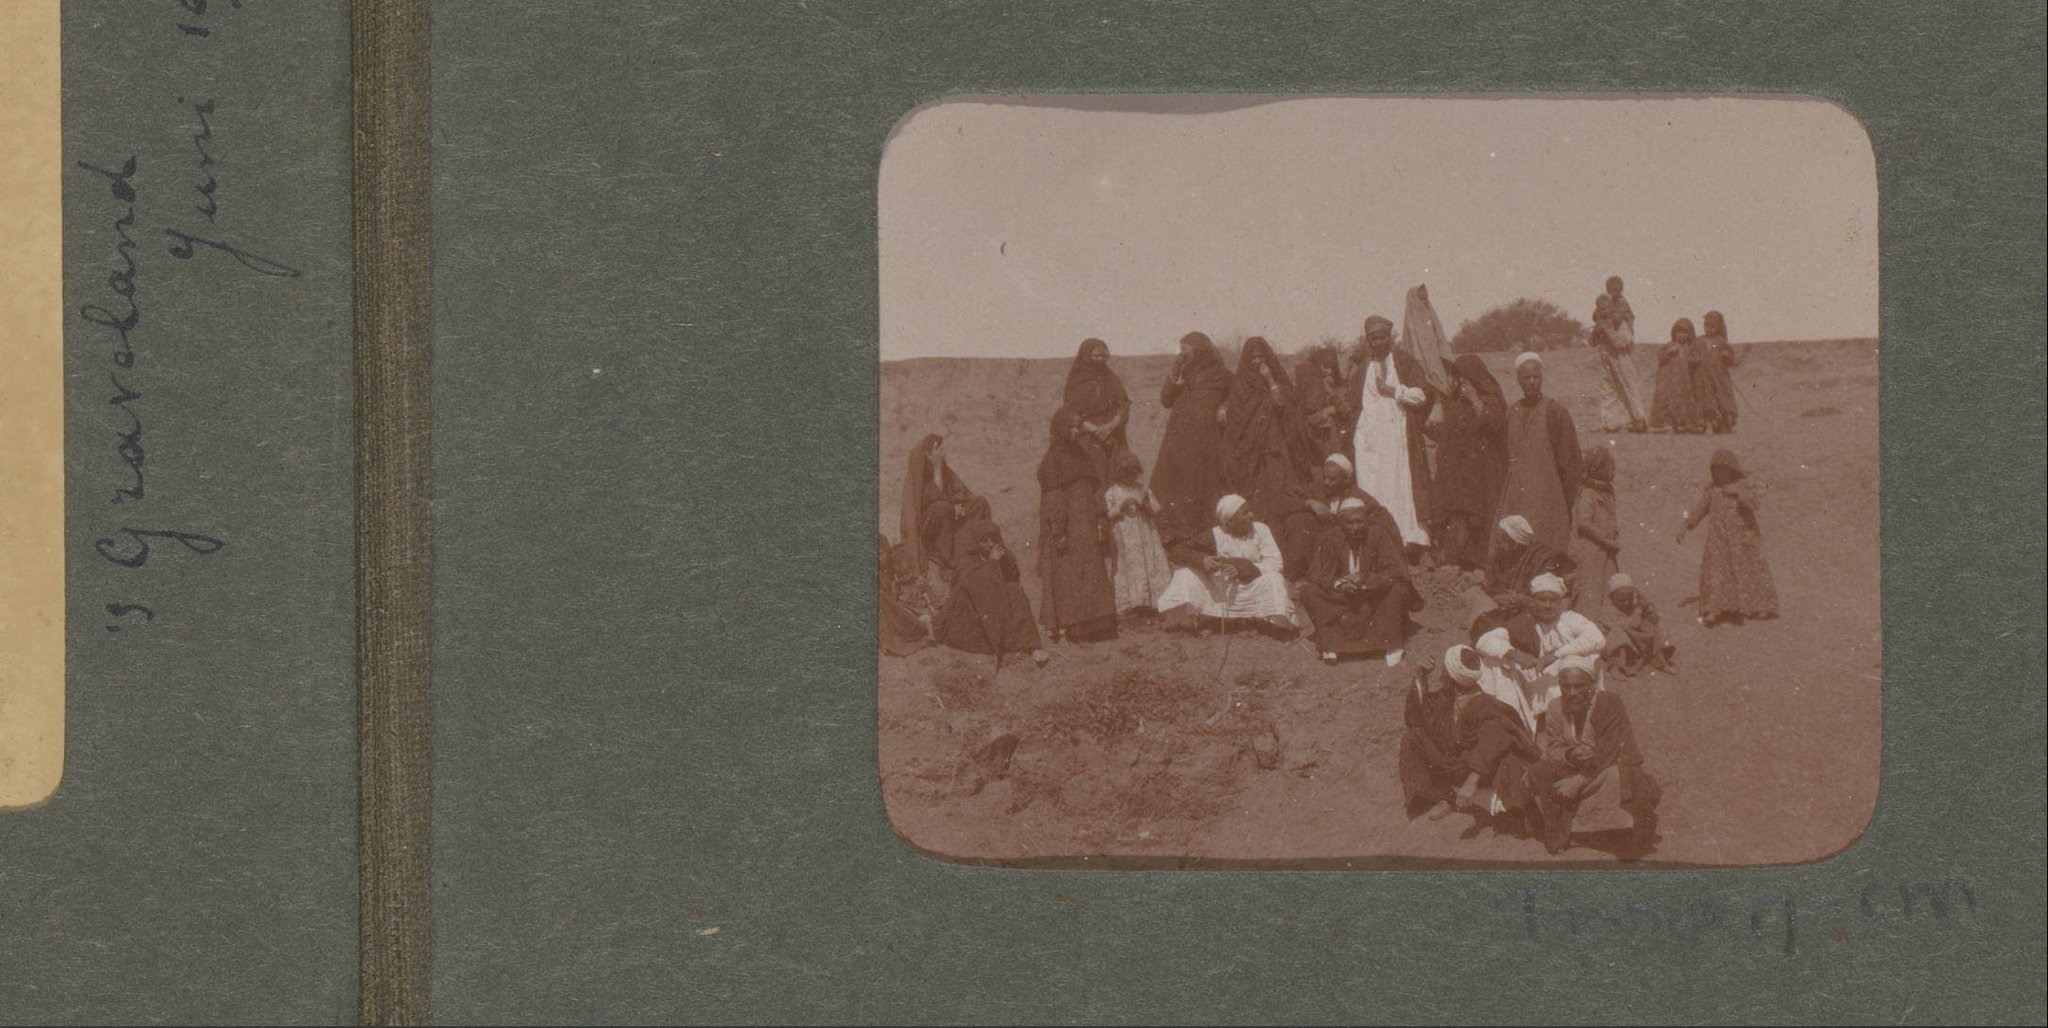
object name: album leaf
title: Groep Egyptische mannen en vrouwen, vermoedelijk langs de Nijl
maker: Anonymous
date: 1903-1905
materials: cardboard, paper, photographic support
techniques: collodion silver print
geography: nile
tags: adult woman, adult man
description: Onderdeel van Reisalbum van een Nederlandse familie met bezienswaardigheden in Europa, Egypte en New York.